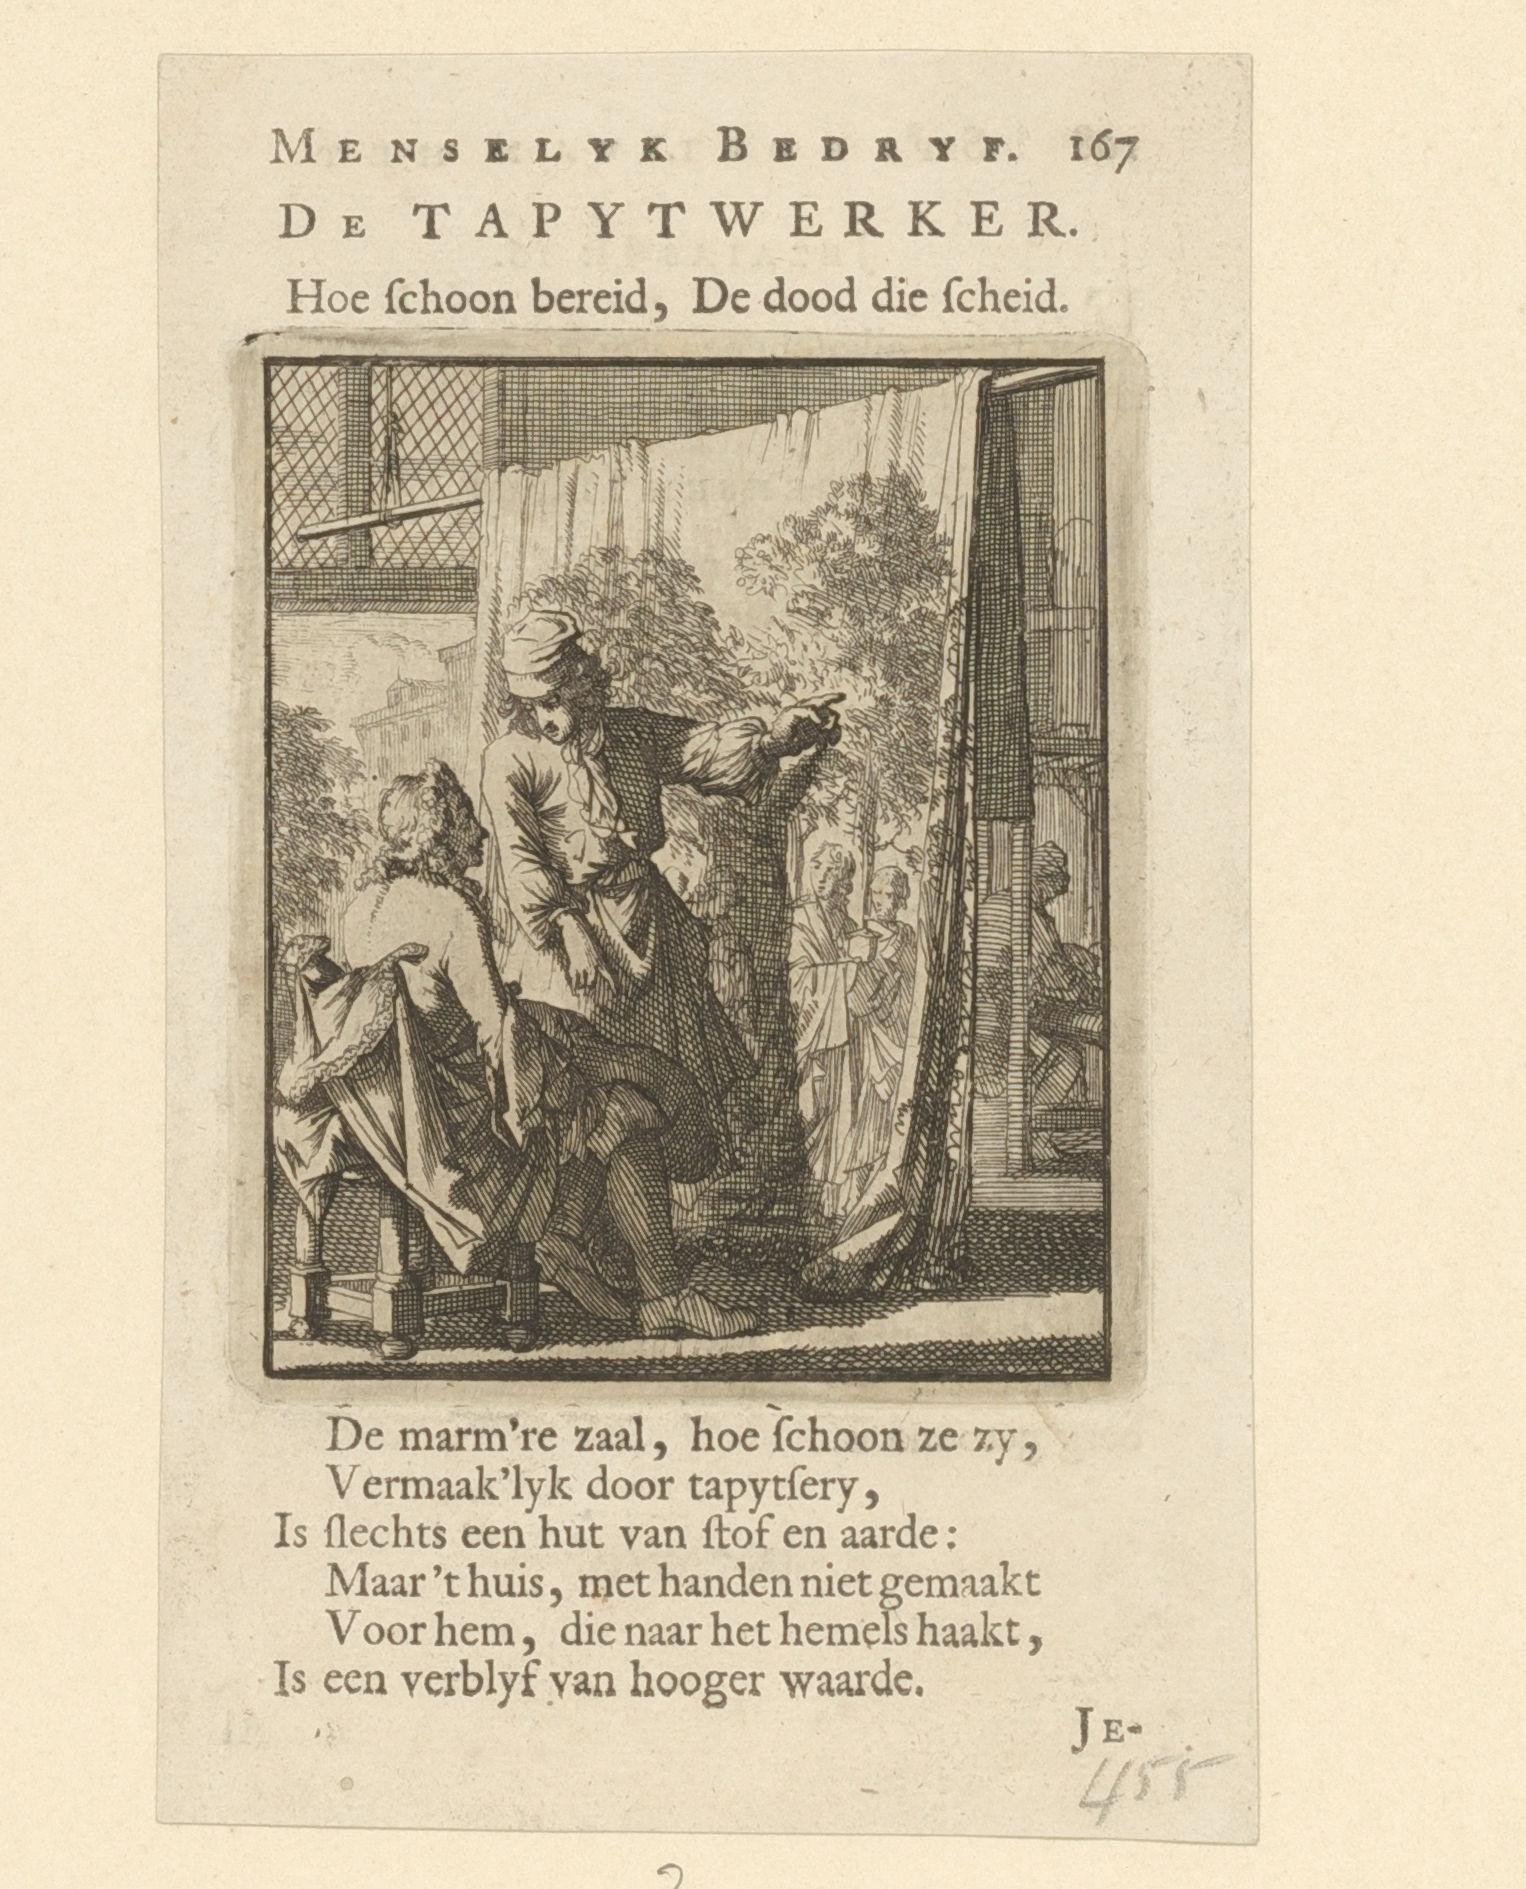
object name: book illustration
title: Tapijtwerker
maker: cornelis van der sys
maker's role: publisher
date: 1718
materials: paper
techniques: etching, letterpress printing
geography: amsterdam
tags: handicrafts, craftsman at work, tapestry weaver, gobelin maker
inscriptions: stamp, collector's mark: Lugt 1641, stamp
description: Prent oorspronkelijk verschenen in de 100-delige serie beroepsprenten van Jan en Caspar Luyken, getiteld: Het menselyk bedryf. S.l.s.n., 1694 (eerste druk). Daarna is de titel en het vers afgesneden. De prenten in diverse publicaties verschenen en gekopieerd. Huidige staat uit: Luyken, Jan en Caspar. Spiegel van het menselyk bedryf (...). Amsterdam: Cornelis van der Sys, 1718, p. 167. Prent waarschijnlijk ook gebruikt in eerdere (1704) en latere (1730, 1749, 1767) publicaties.